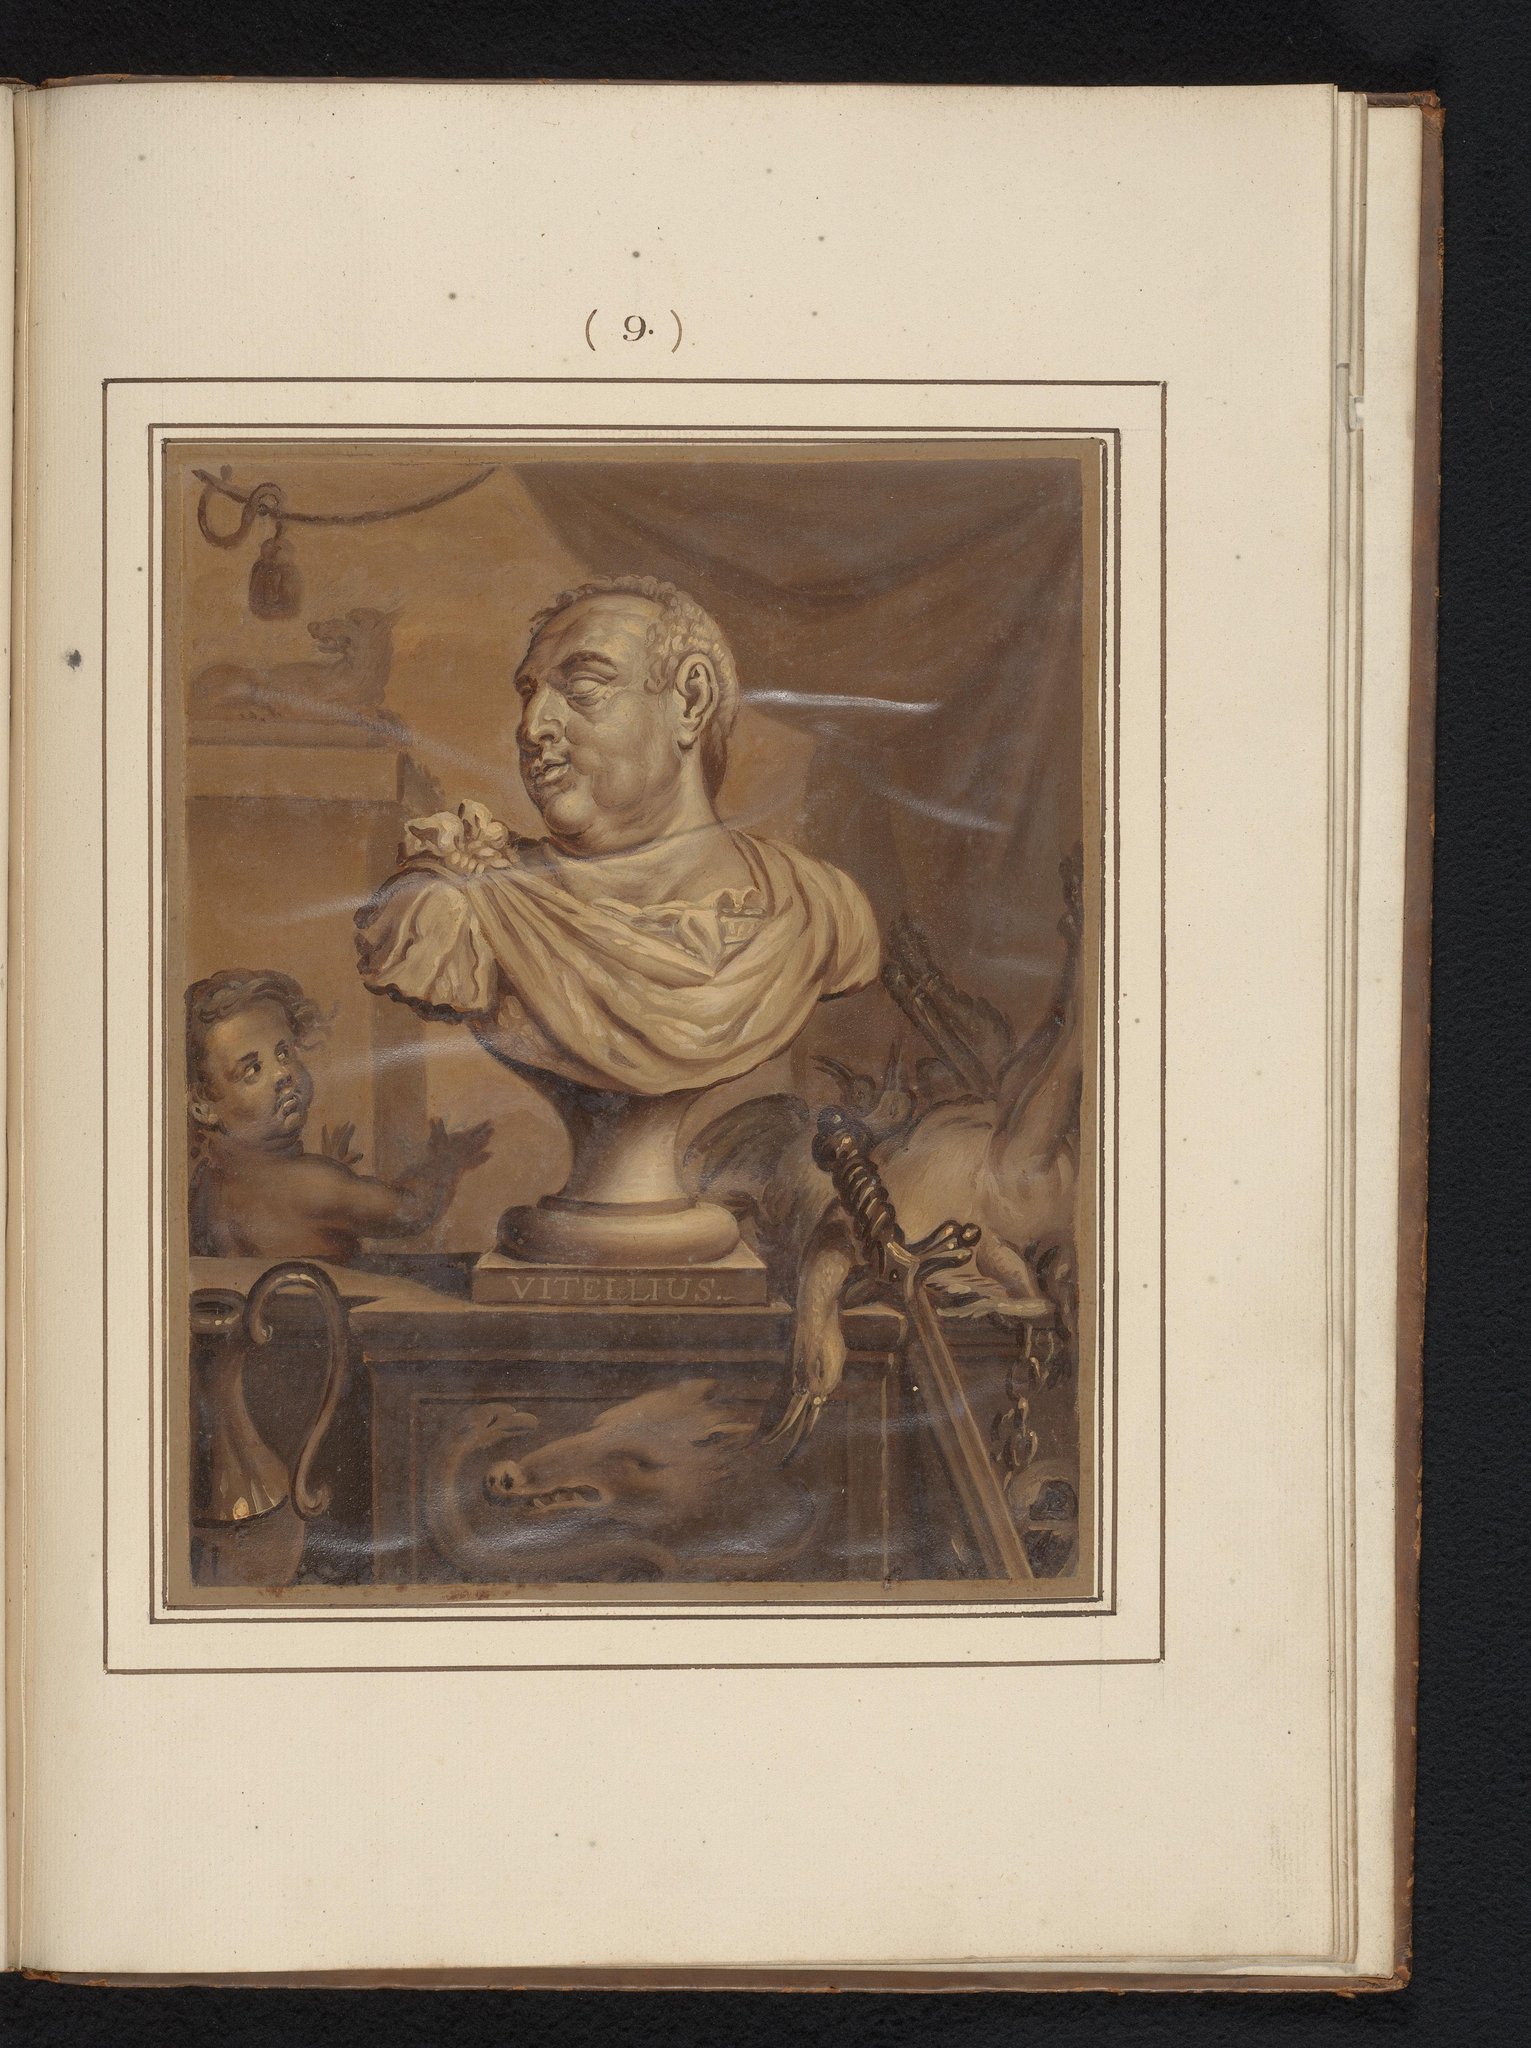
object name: drawing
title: Portret van keizer Vitellius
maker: pieter anthony wakkerdak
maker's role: print maker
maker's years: 1729-1774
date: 1773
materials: paint, paper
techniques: brush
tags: rome, historical persons, emperor, cupids: 'amores', 'amoretti', 'putti'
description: Tekening maakt deel uit van een manuscript.